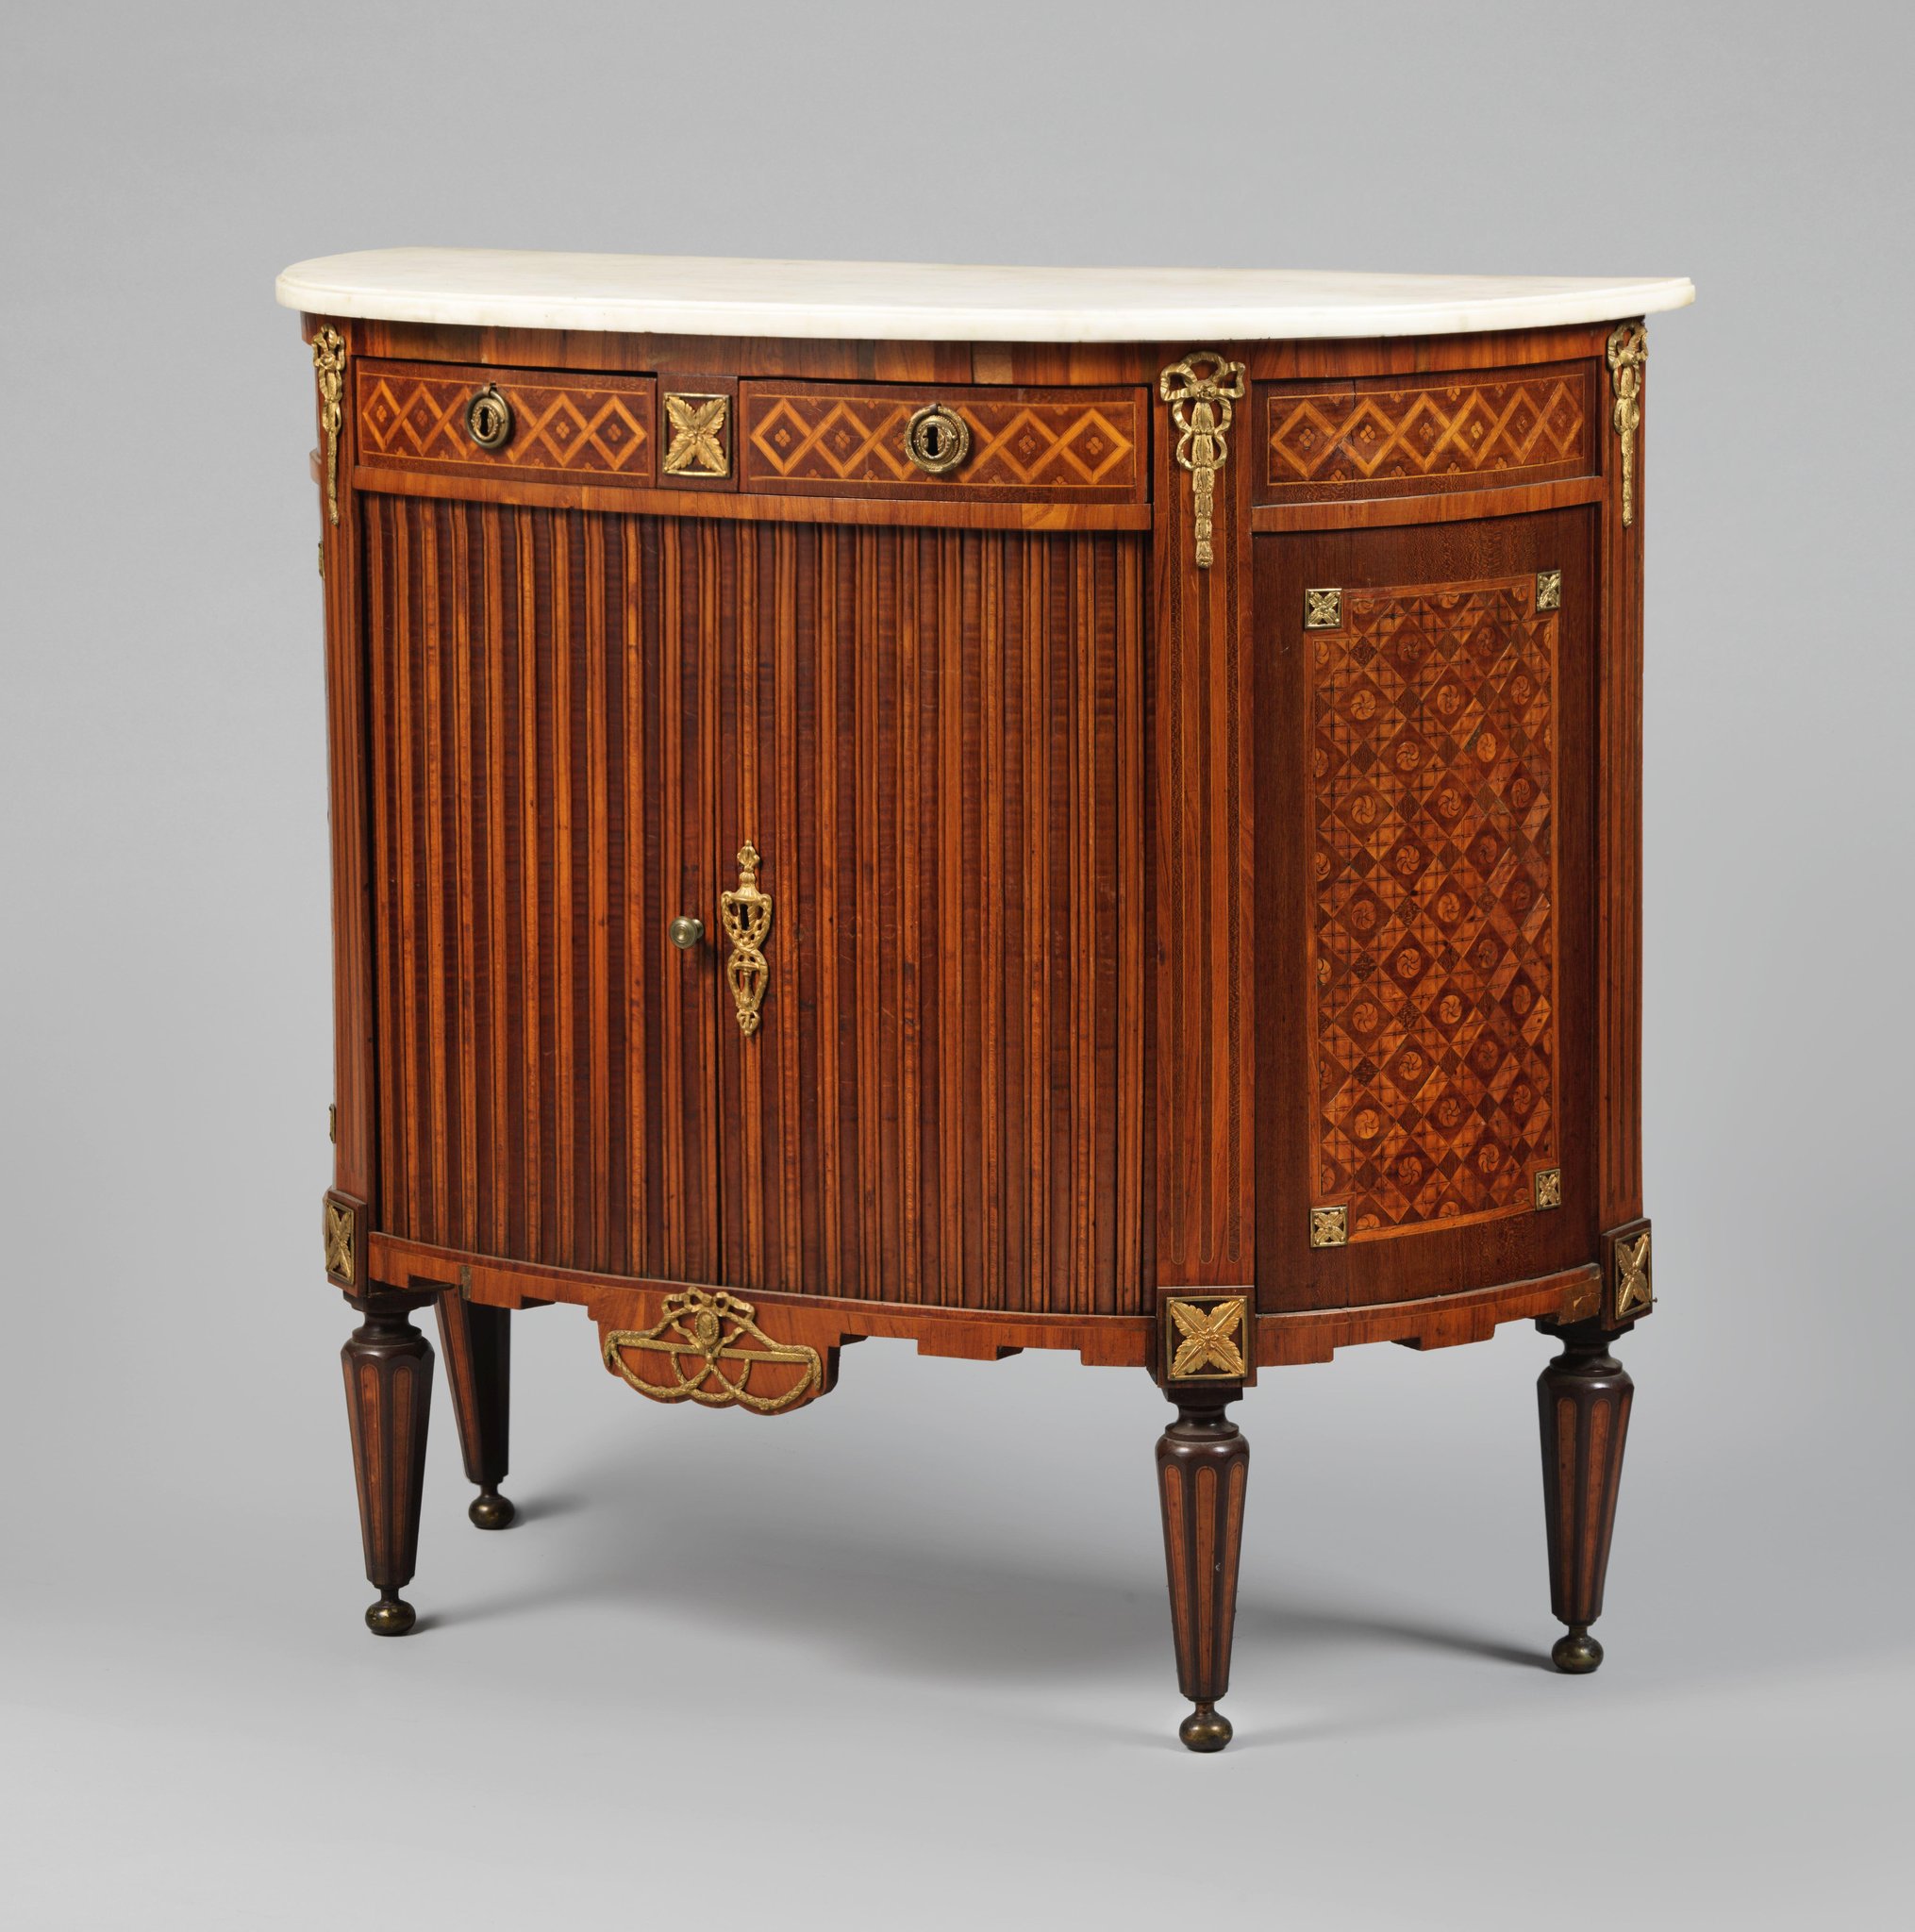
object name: furniture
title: Penantkast met gebogen wanden, cilinderdeuren en marmeren blad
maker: Anonymous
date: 1775-1800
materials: wood, copper, marble, metal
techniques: gilding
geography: northern netherlands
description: Penantkast versierd met marqueterie van roze-, kerse- en satijnhout en bedekt met een witmarmeren plaat. Het kastje is half ovaal van doorsnede. Het front heeft twee cylinderdeuren; de gebogen wanden zijn belijmd met geometrische figuren in rechthoekige velden. In de bovendorpel van het front twee laden. De vier conische poten hebben verguld koperen voeten. Op de stijlen, zijwanden, deuren en dorpels verguld koperen beslag. Behorend bij een andere penantkast, zie: BK-NM-8840.